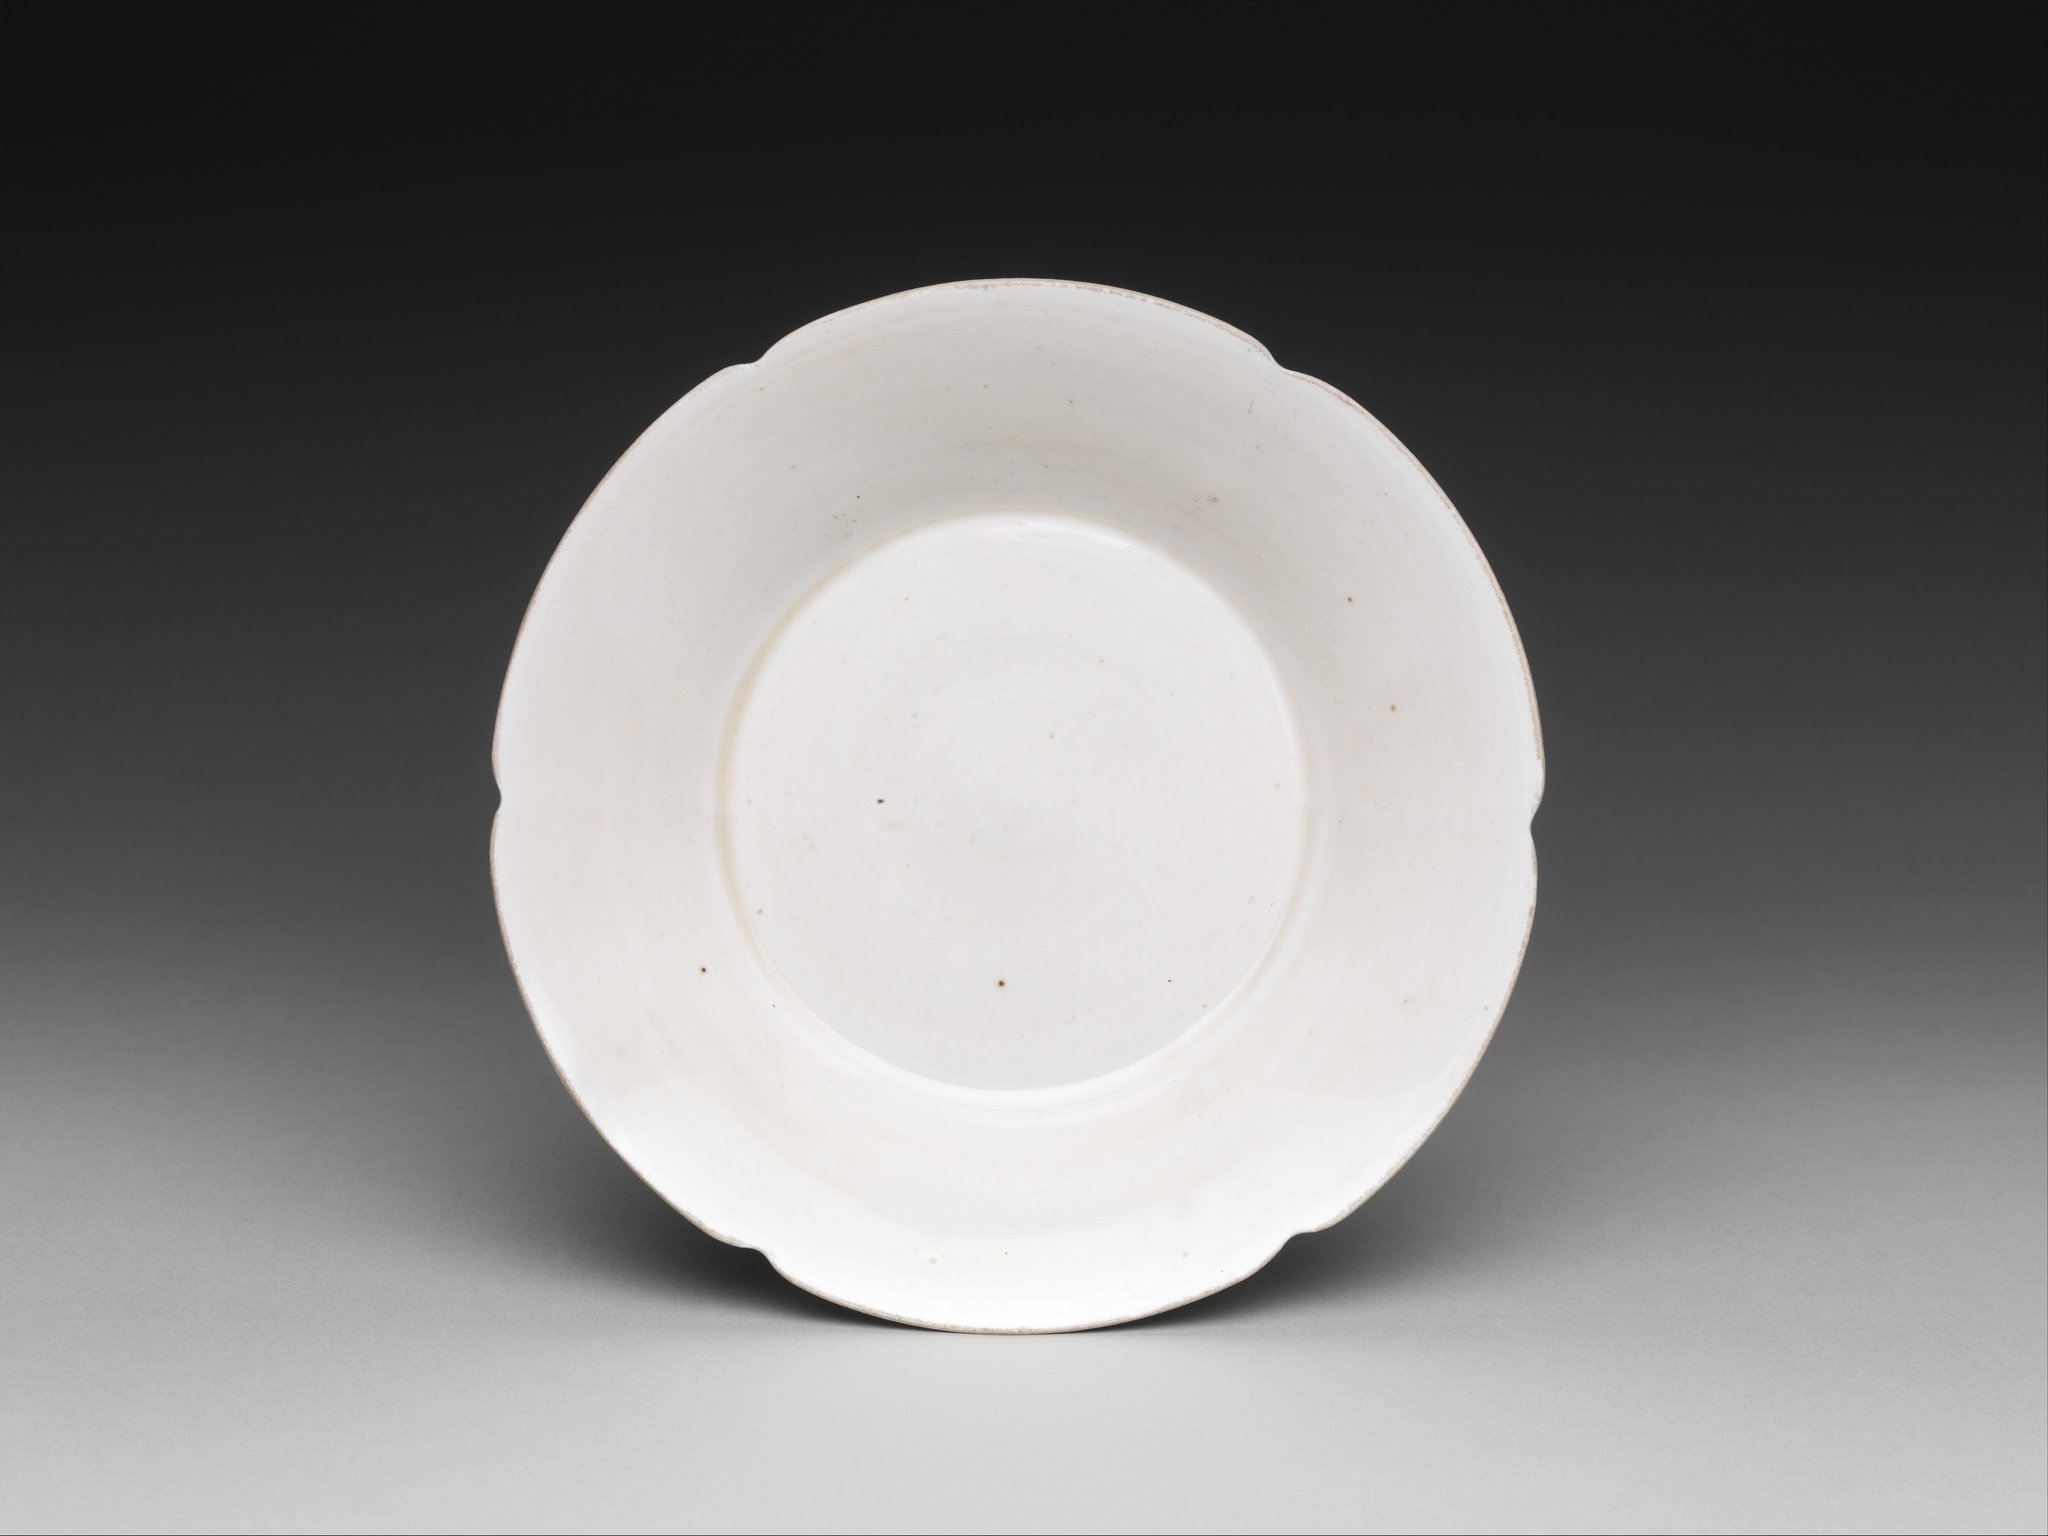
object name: dish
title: Dish with Scalloped Rim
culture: chinese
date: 1001-1100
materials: glaze, ivory, porcelain